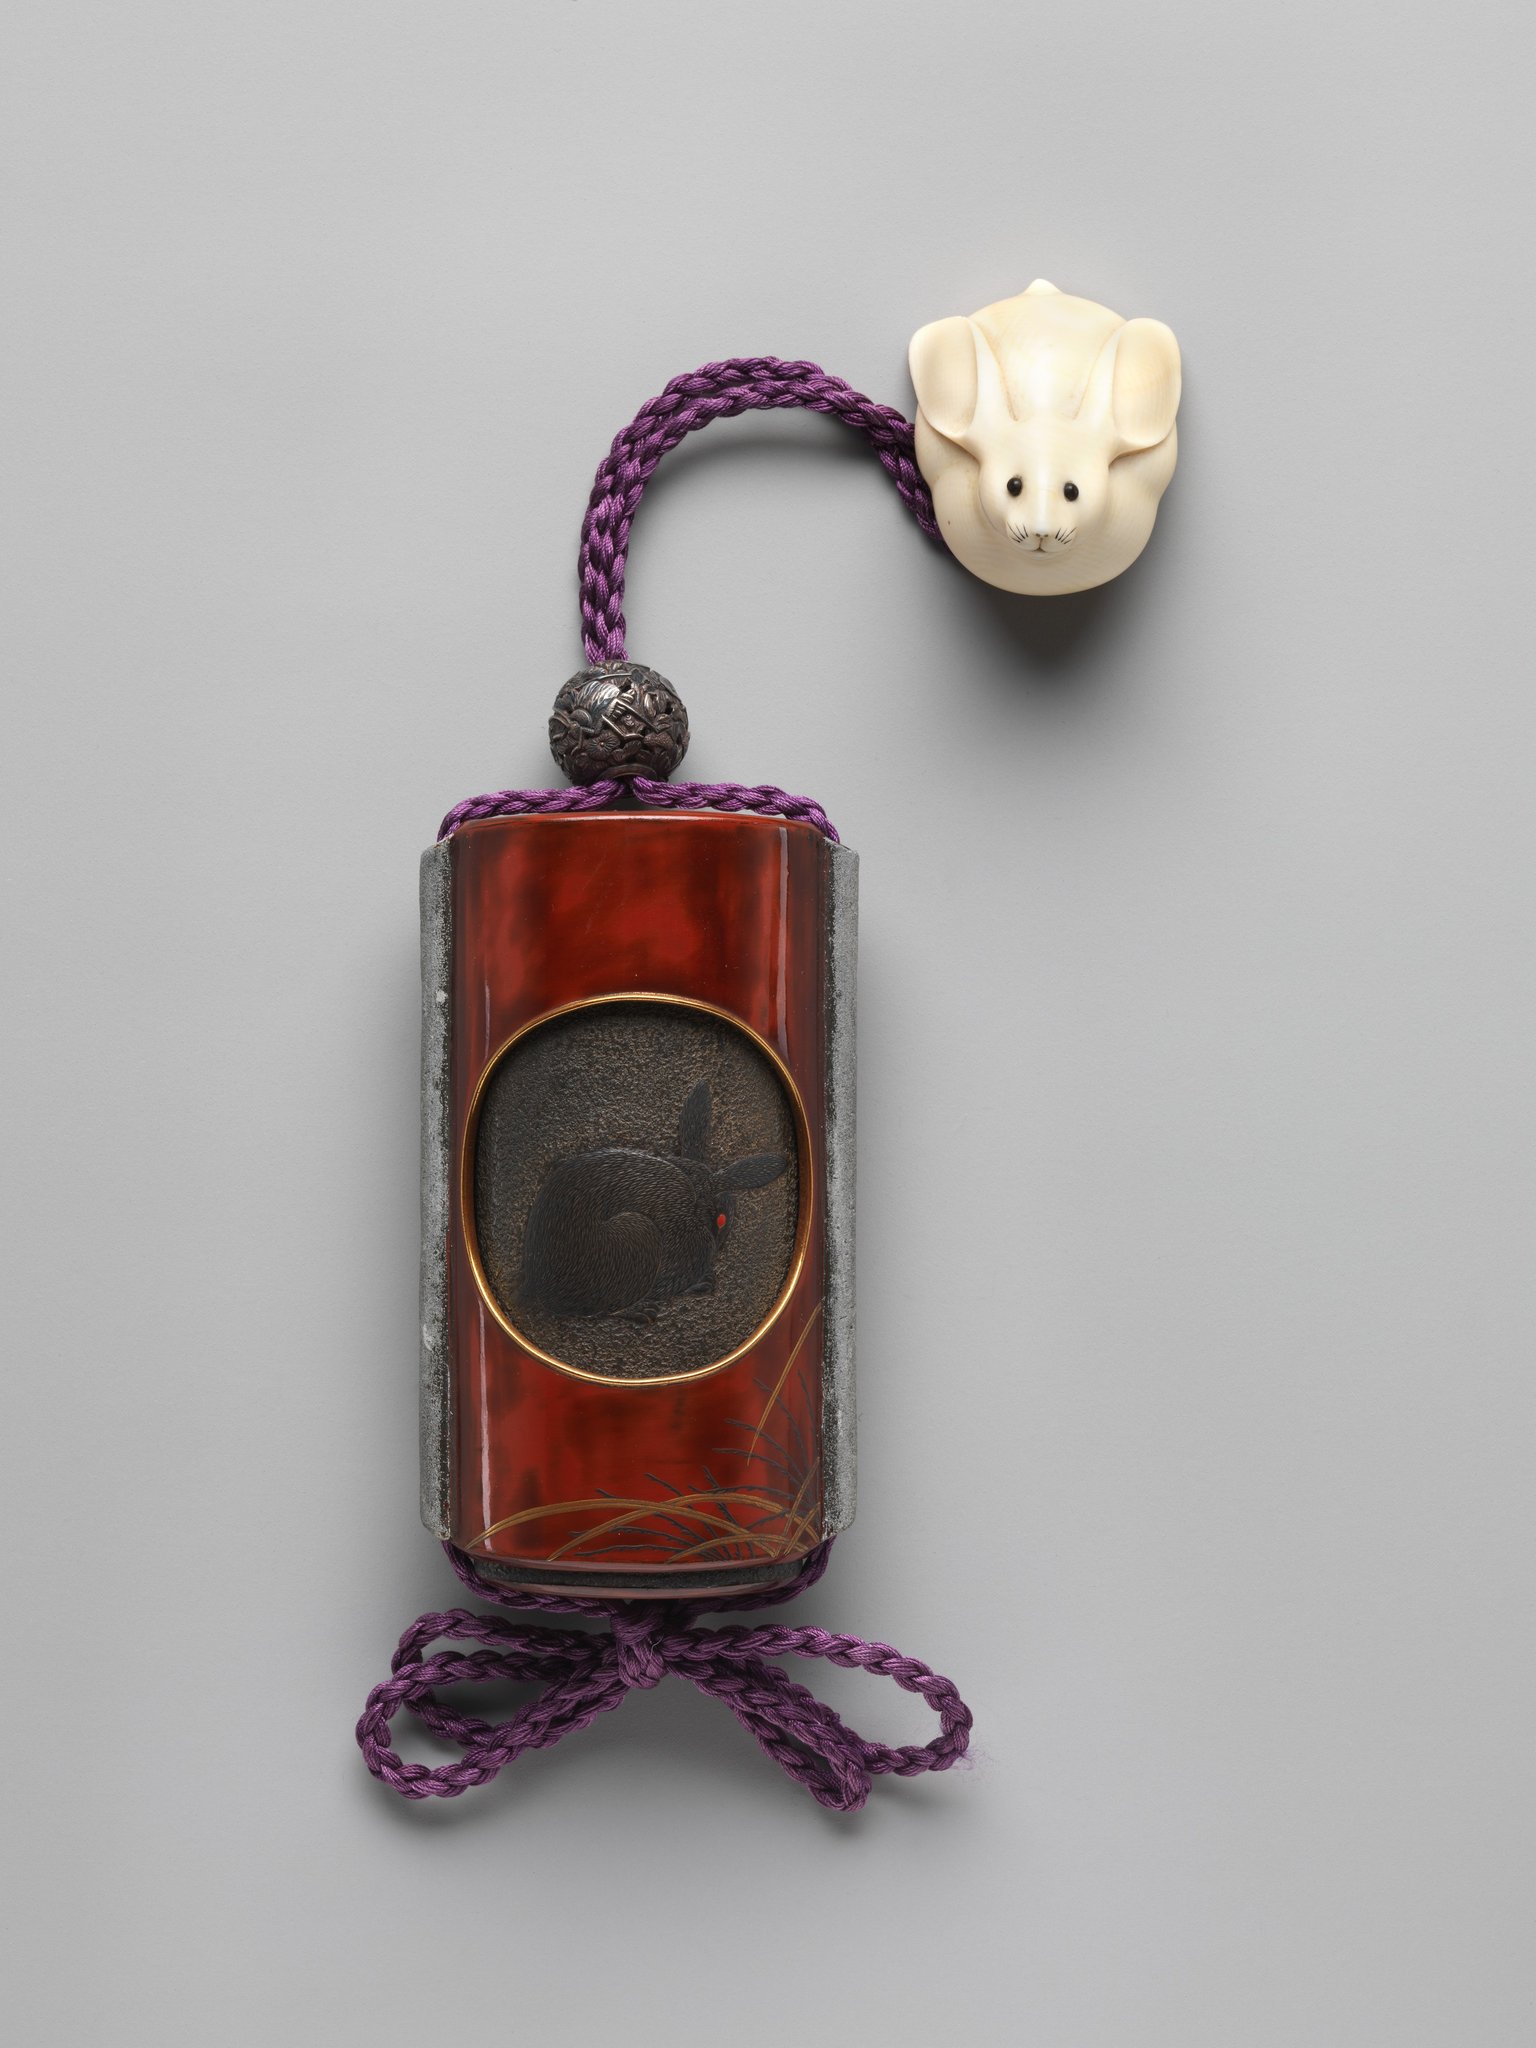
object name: inrō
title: Inrō with Rabbit in the Moon and Autumn Grasses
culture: japanese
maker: kyūkoku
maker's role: artist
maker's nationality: japanese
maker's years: 1800-1849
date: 1801-1850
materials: gold, ivory, lacquer, metal, pewter, silver, wood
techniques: hiramakie, lacquer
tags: rabbits